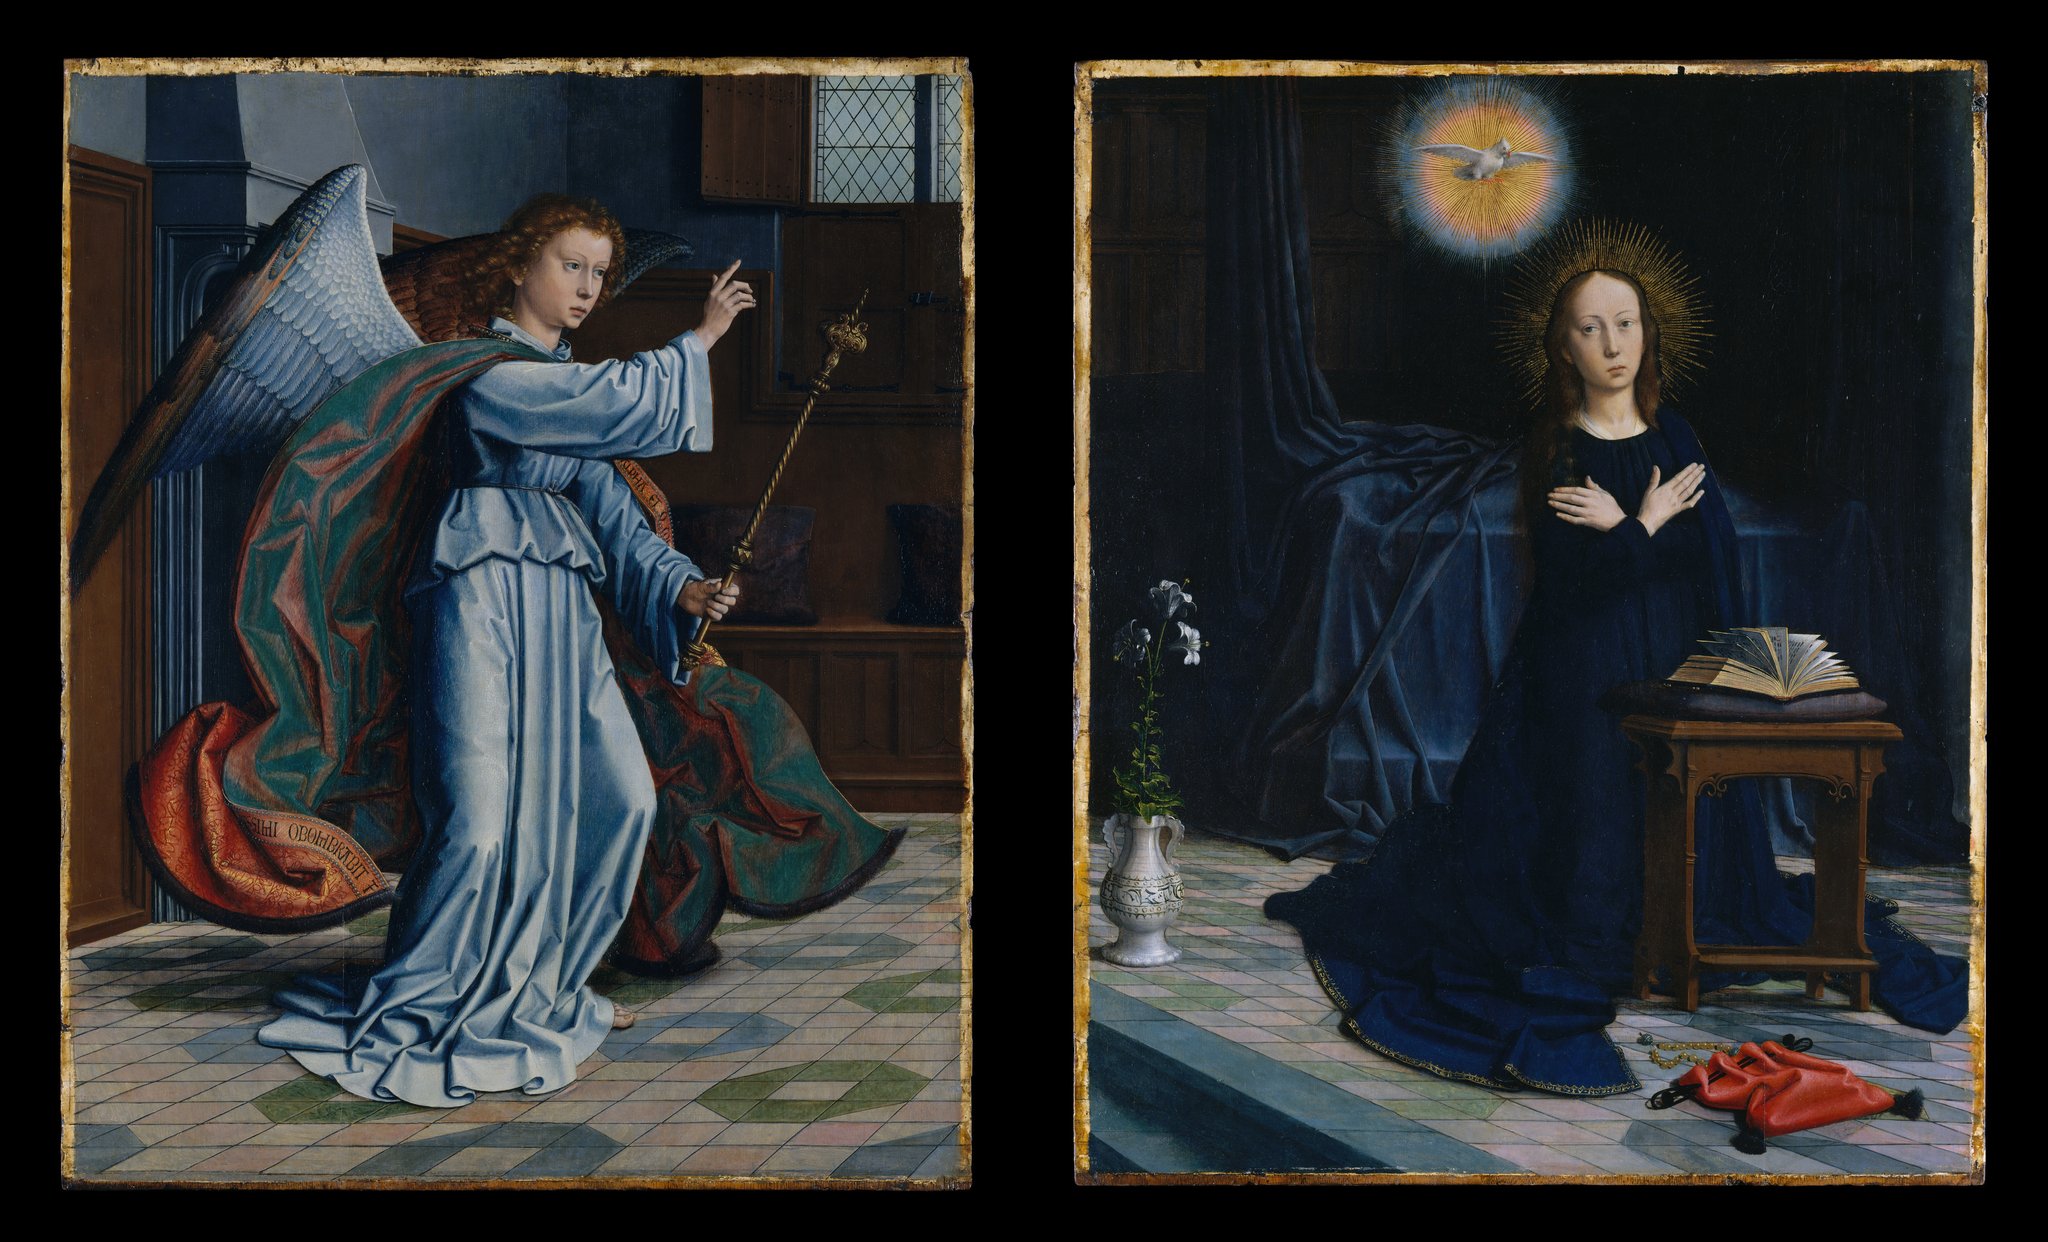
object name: painting, part of a polyptych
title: The Annunciation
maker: gerard david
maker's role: artist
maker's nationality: netherlandish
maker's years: 1455-1523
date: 1506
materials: oil, wood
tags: virgin mary,archangel gabriel,annunciation,beds